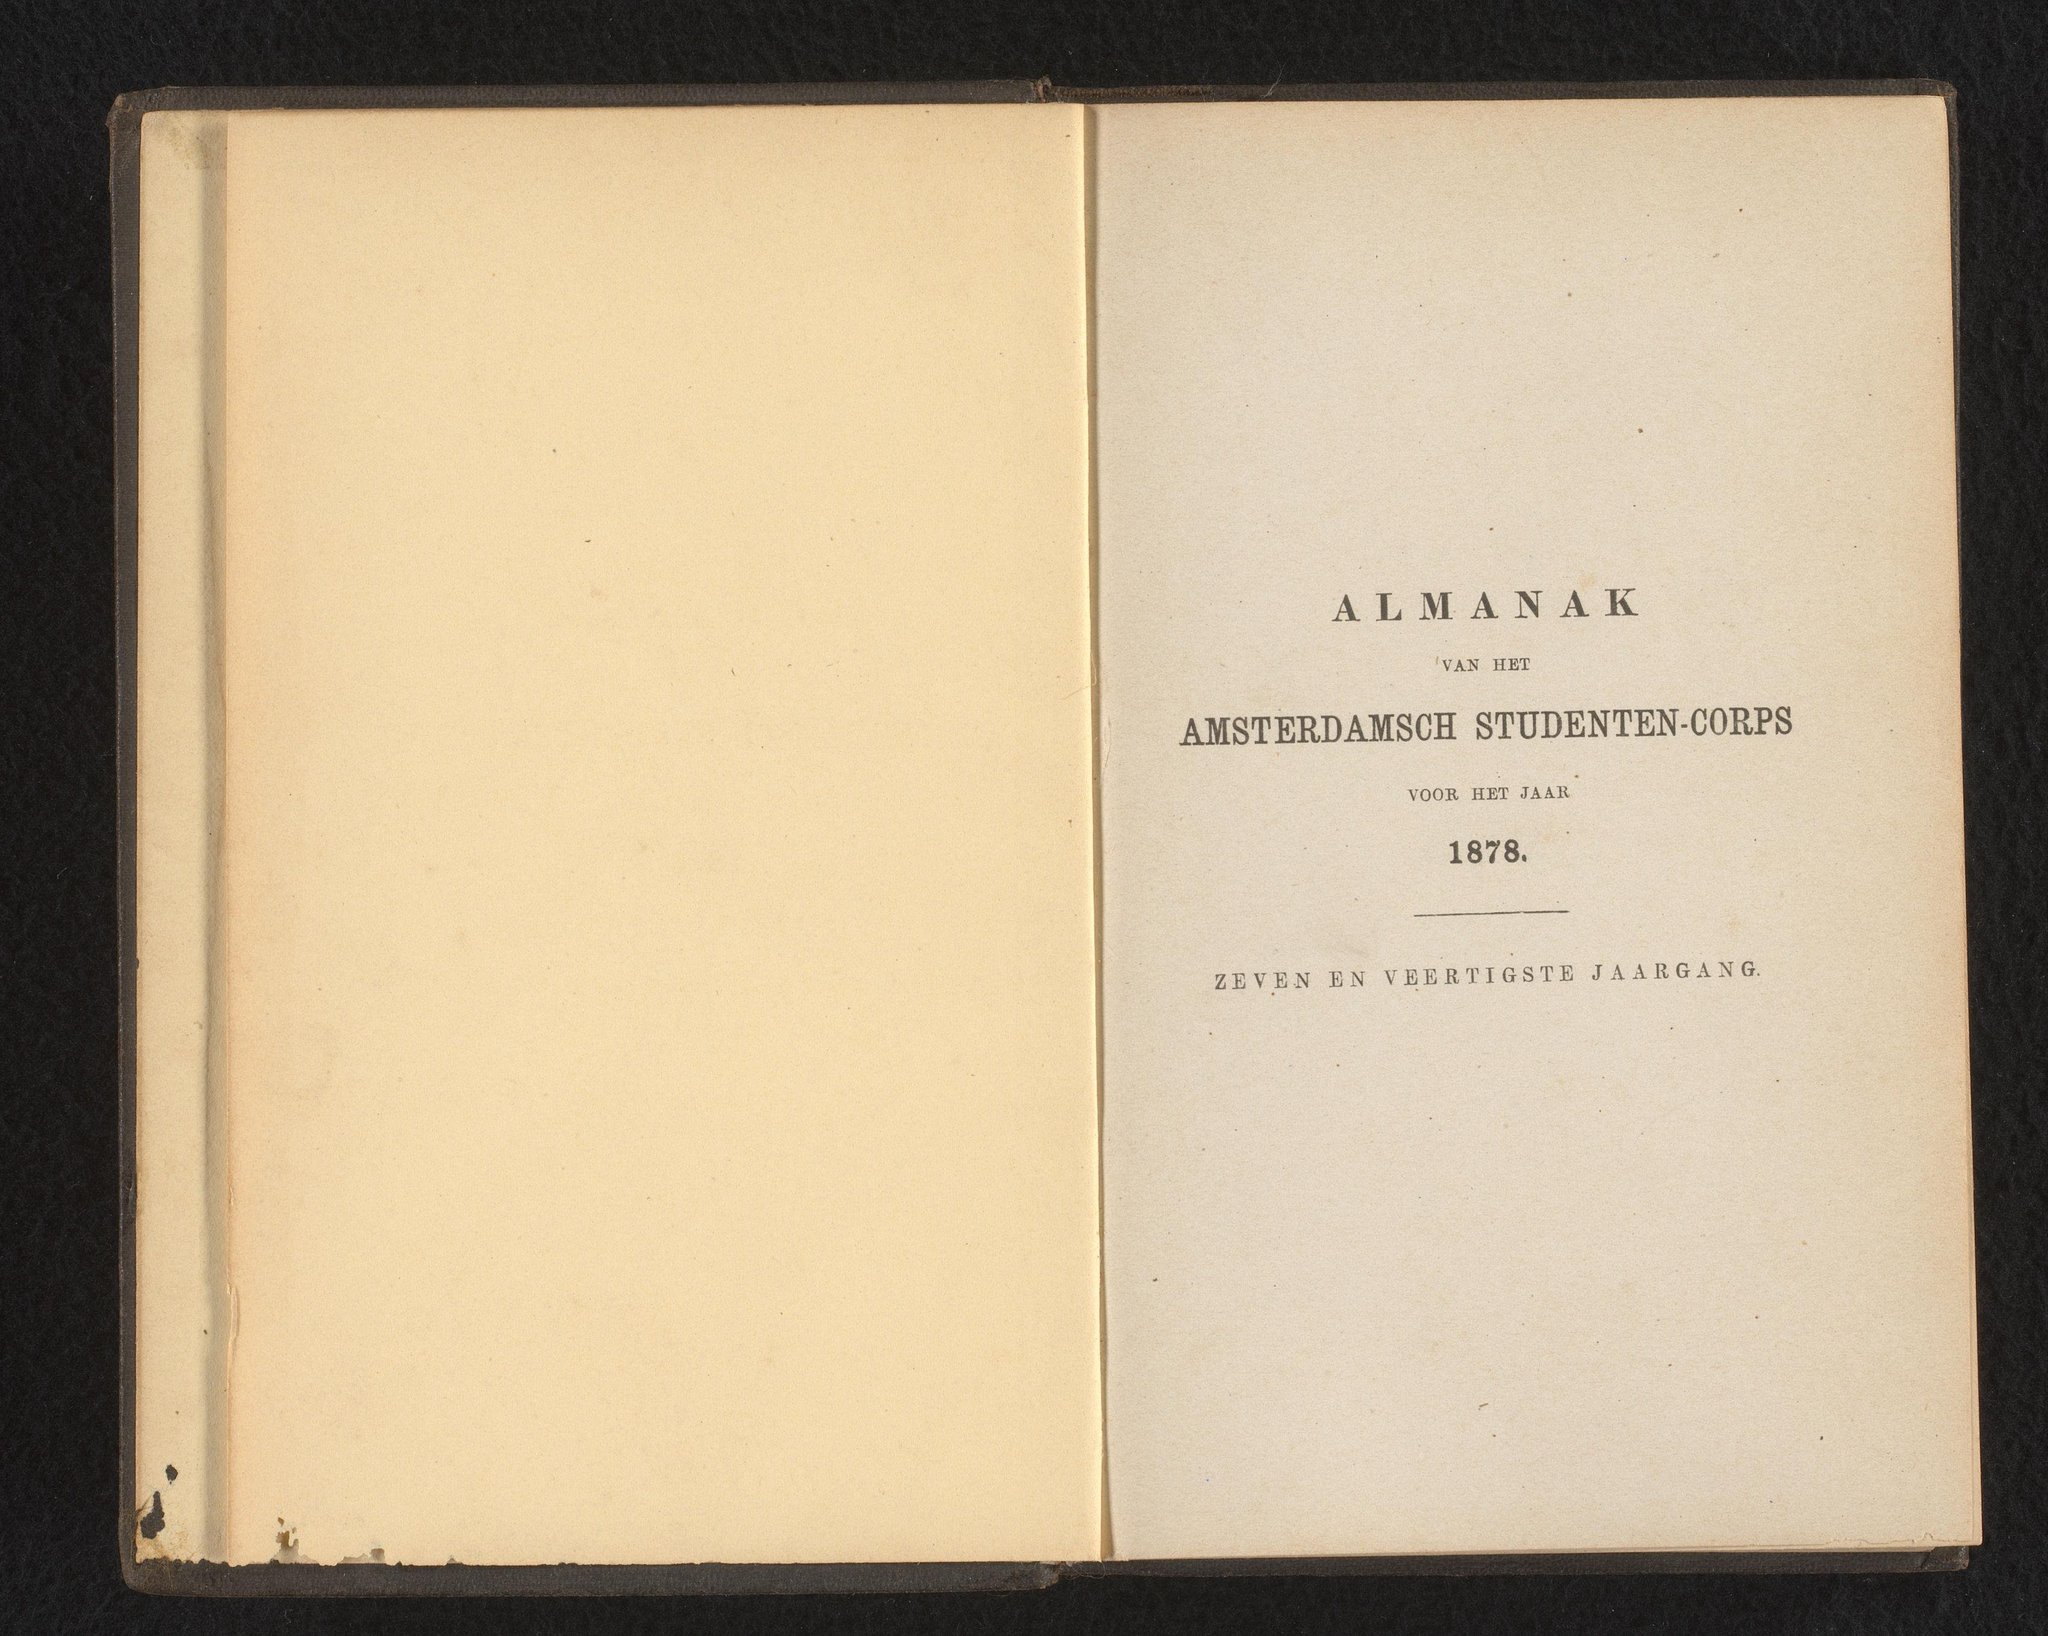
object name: book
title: Almanak van het Amsterdamsch studenten-corps voor het jaar 1878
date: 1878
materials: cardboard, linen, paper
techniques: albumen print, engraving, letterpress printing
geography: amsterdam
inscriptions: inscription: ‘gekocht dec 1964 f3,-/ bij Narrenschip Amsterdam’